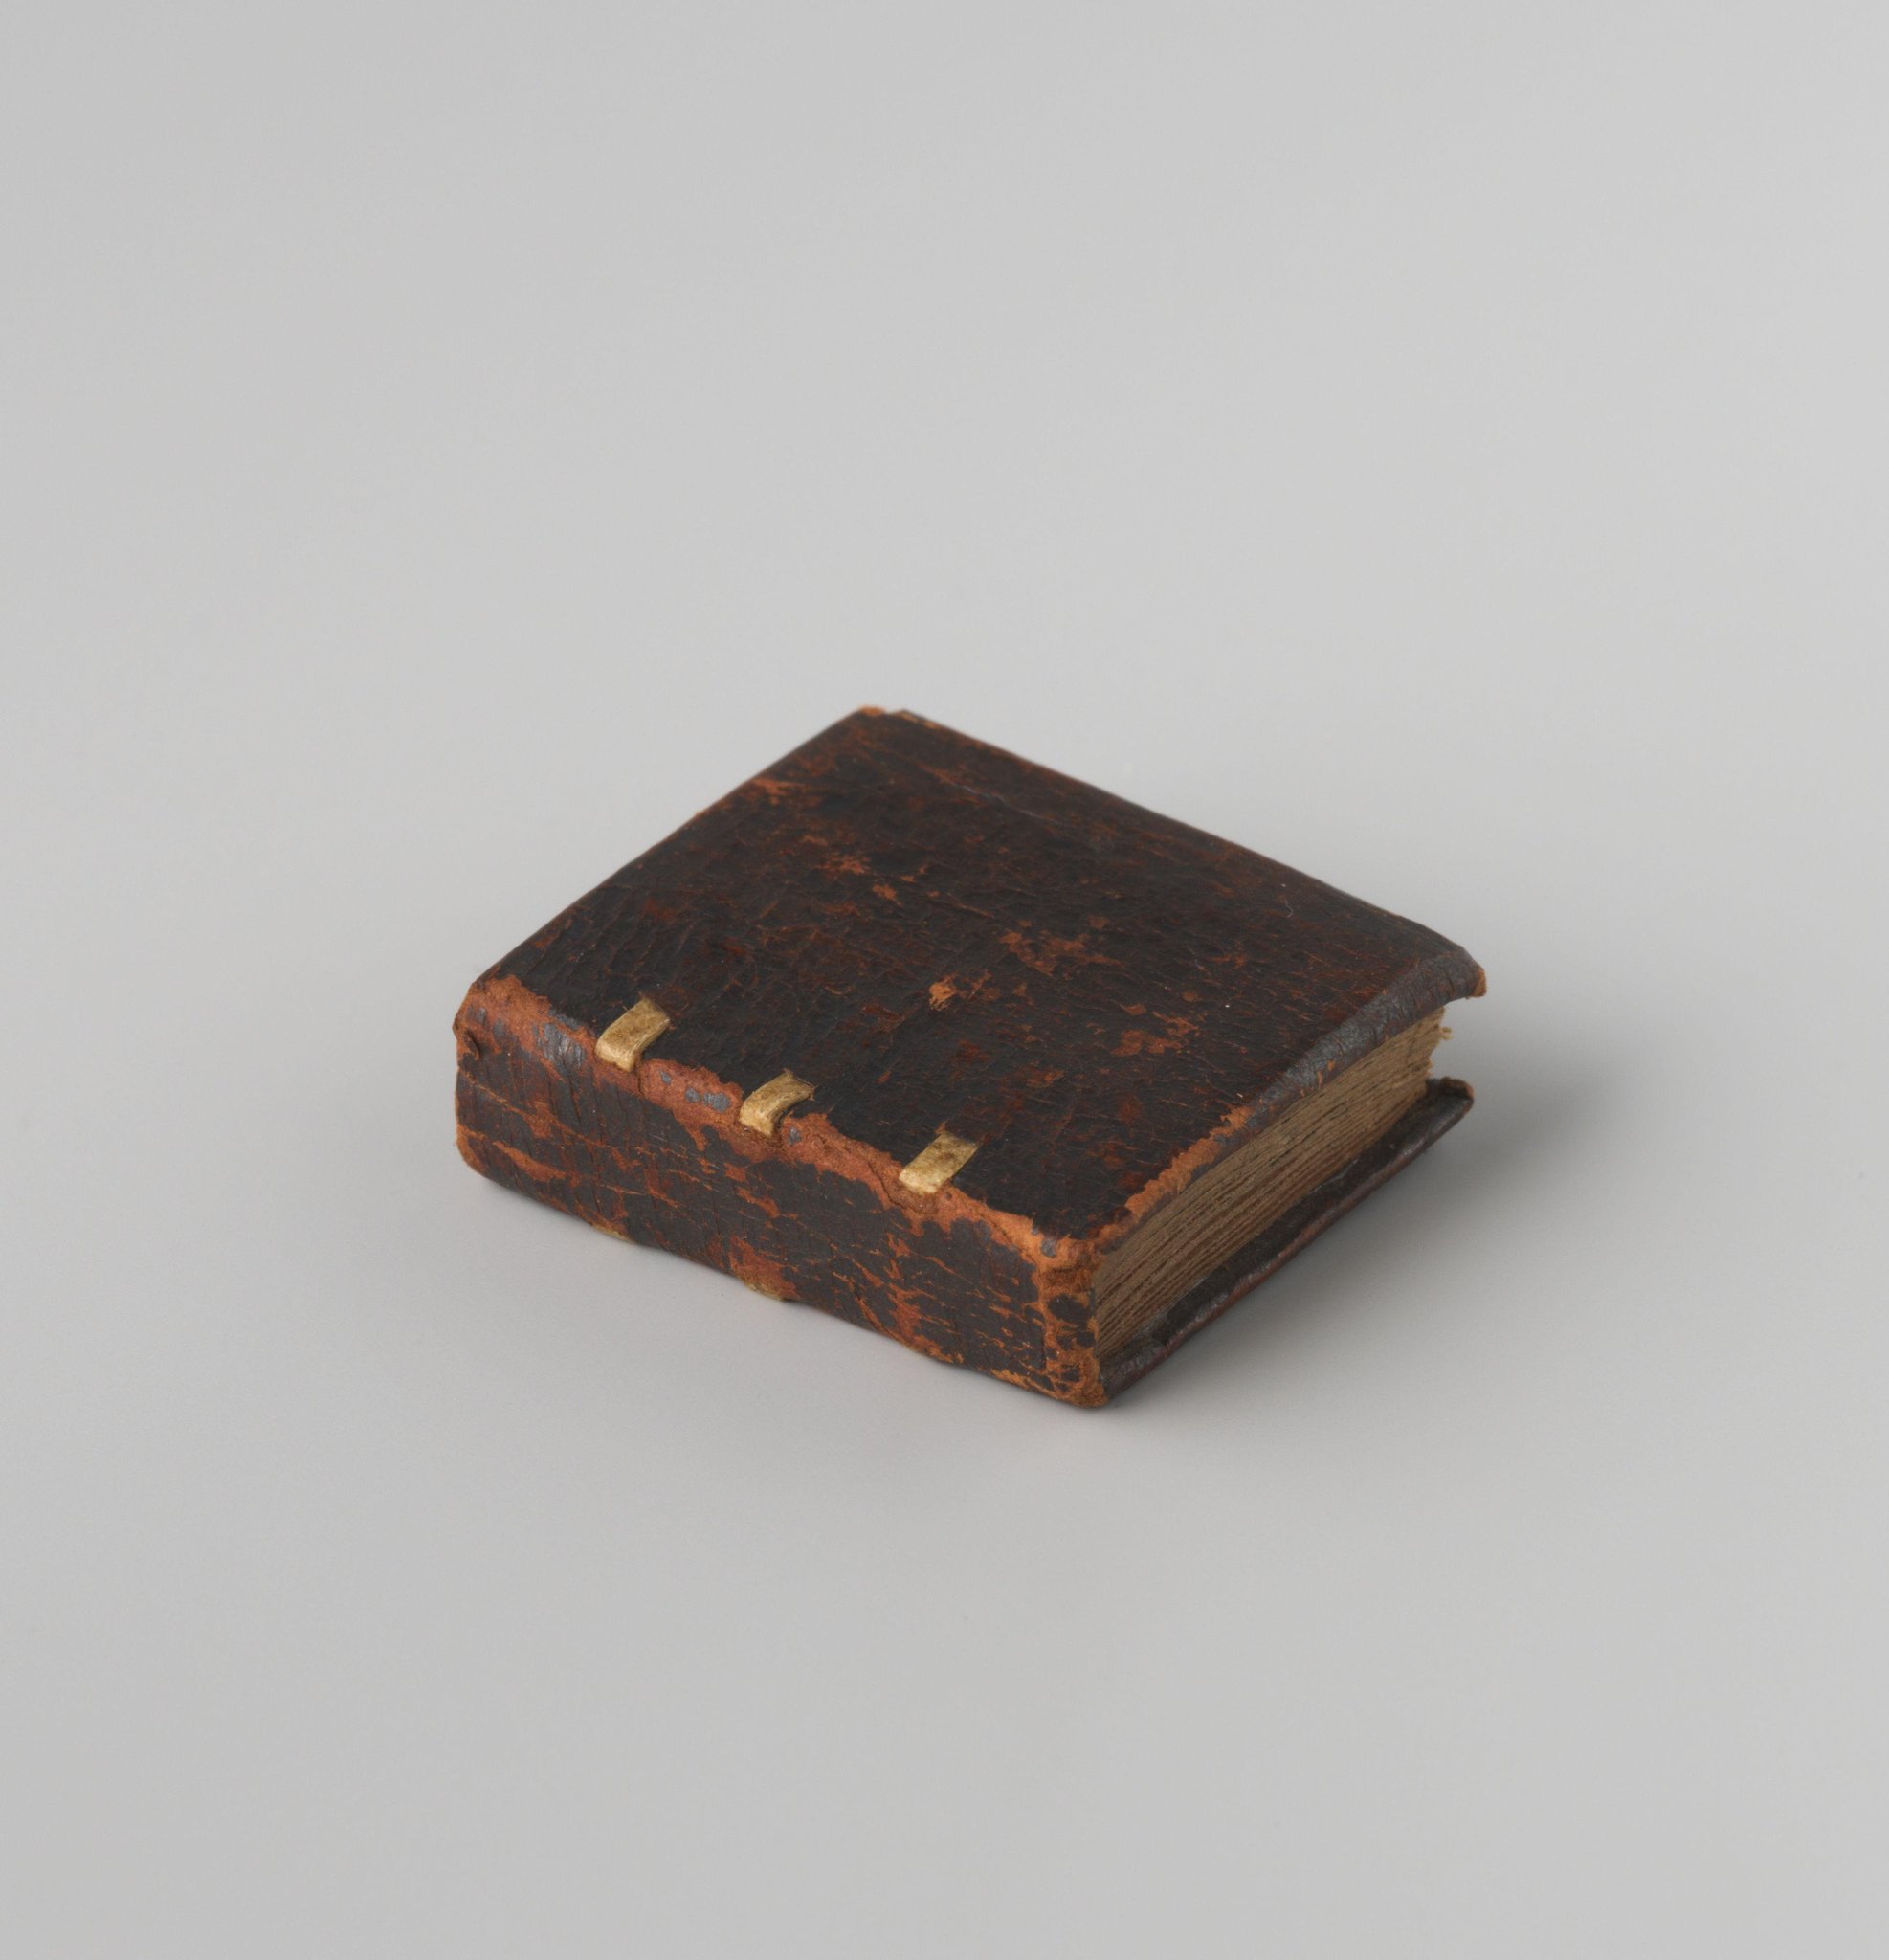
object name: ordinary of arm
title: Wapenboek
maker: Anonymous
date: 1690-1710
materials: leather, paper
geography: amsterdam